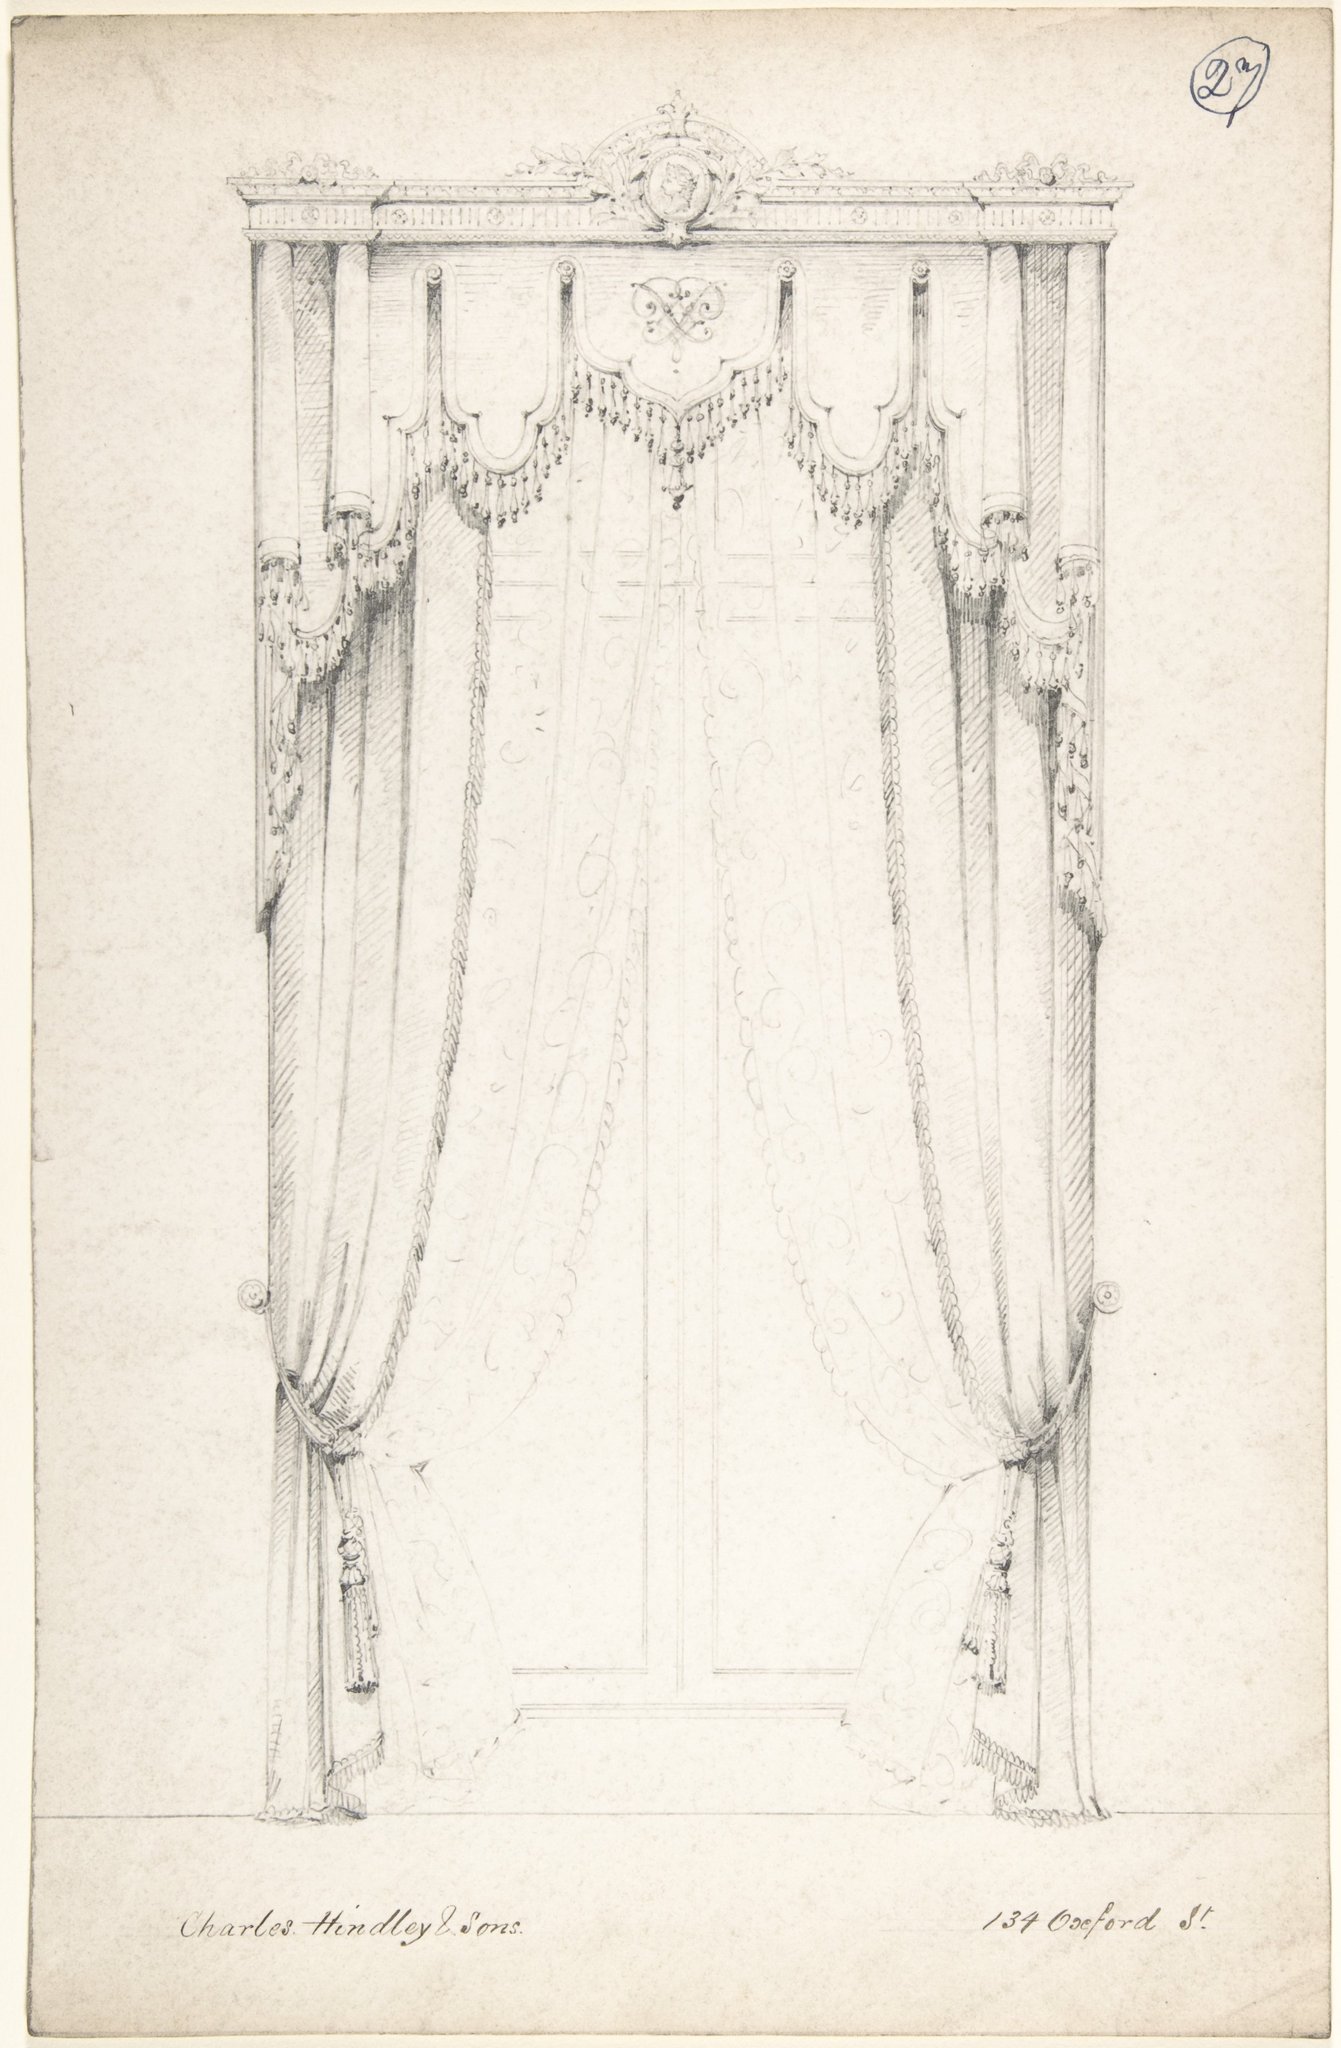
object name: drawing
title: Design for Curtains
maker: charles hindley and sons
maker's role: artist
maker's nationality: british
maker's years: 1841-1917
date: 1841-1884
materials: graphite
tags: curtains